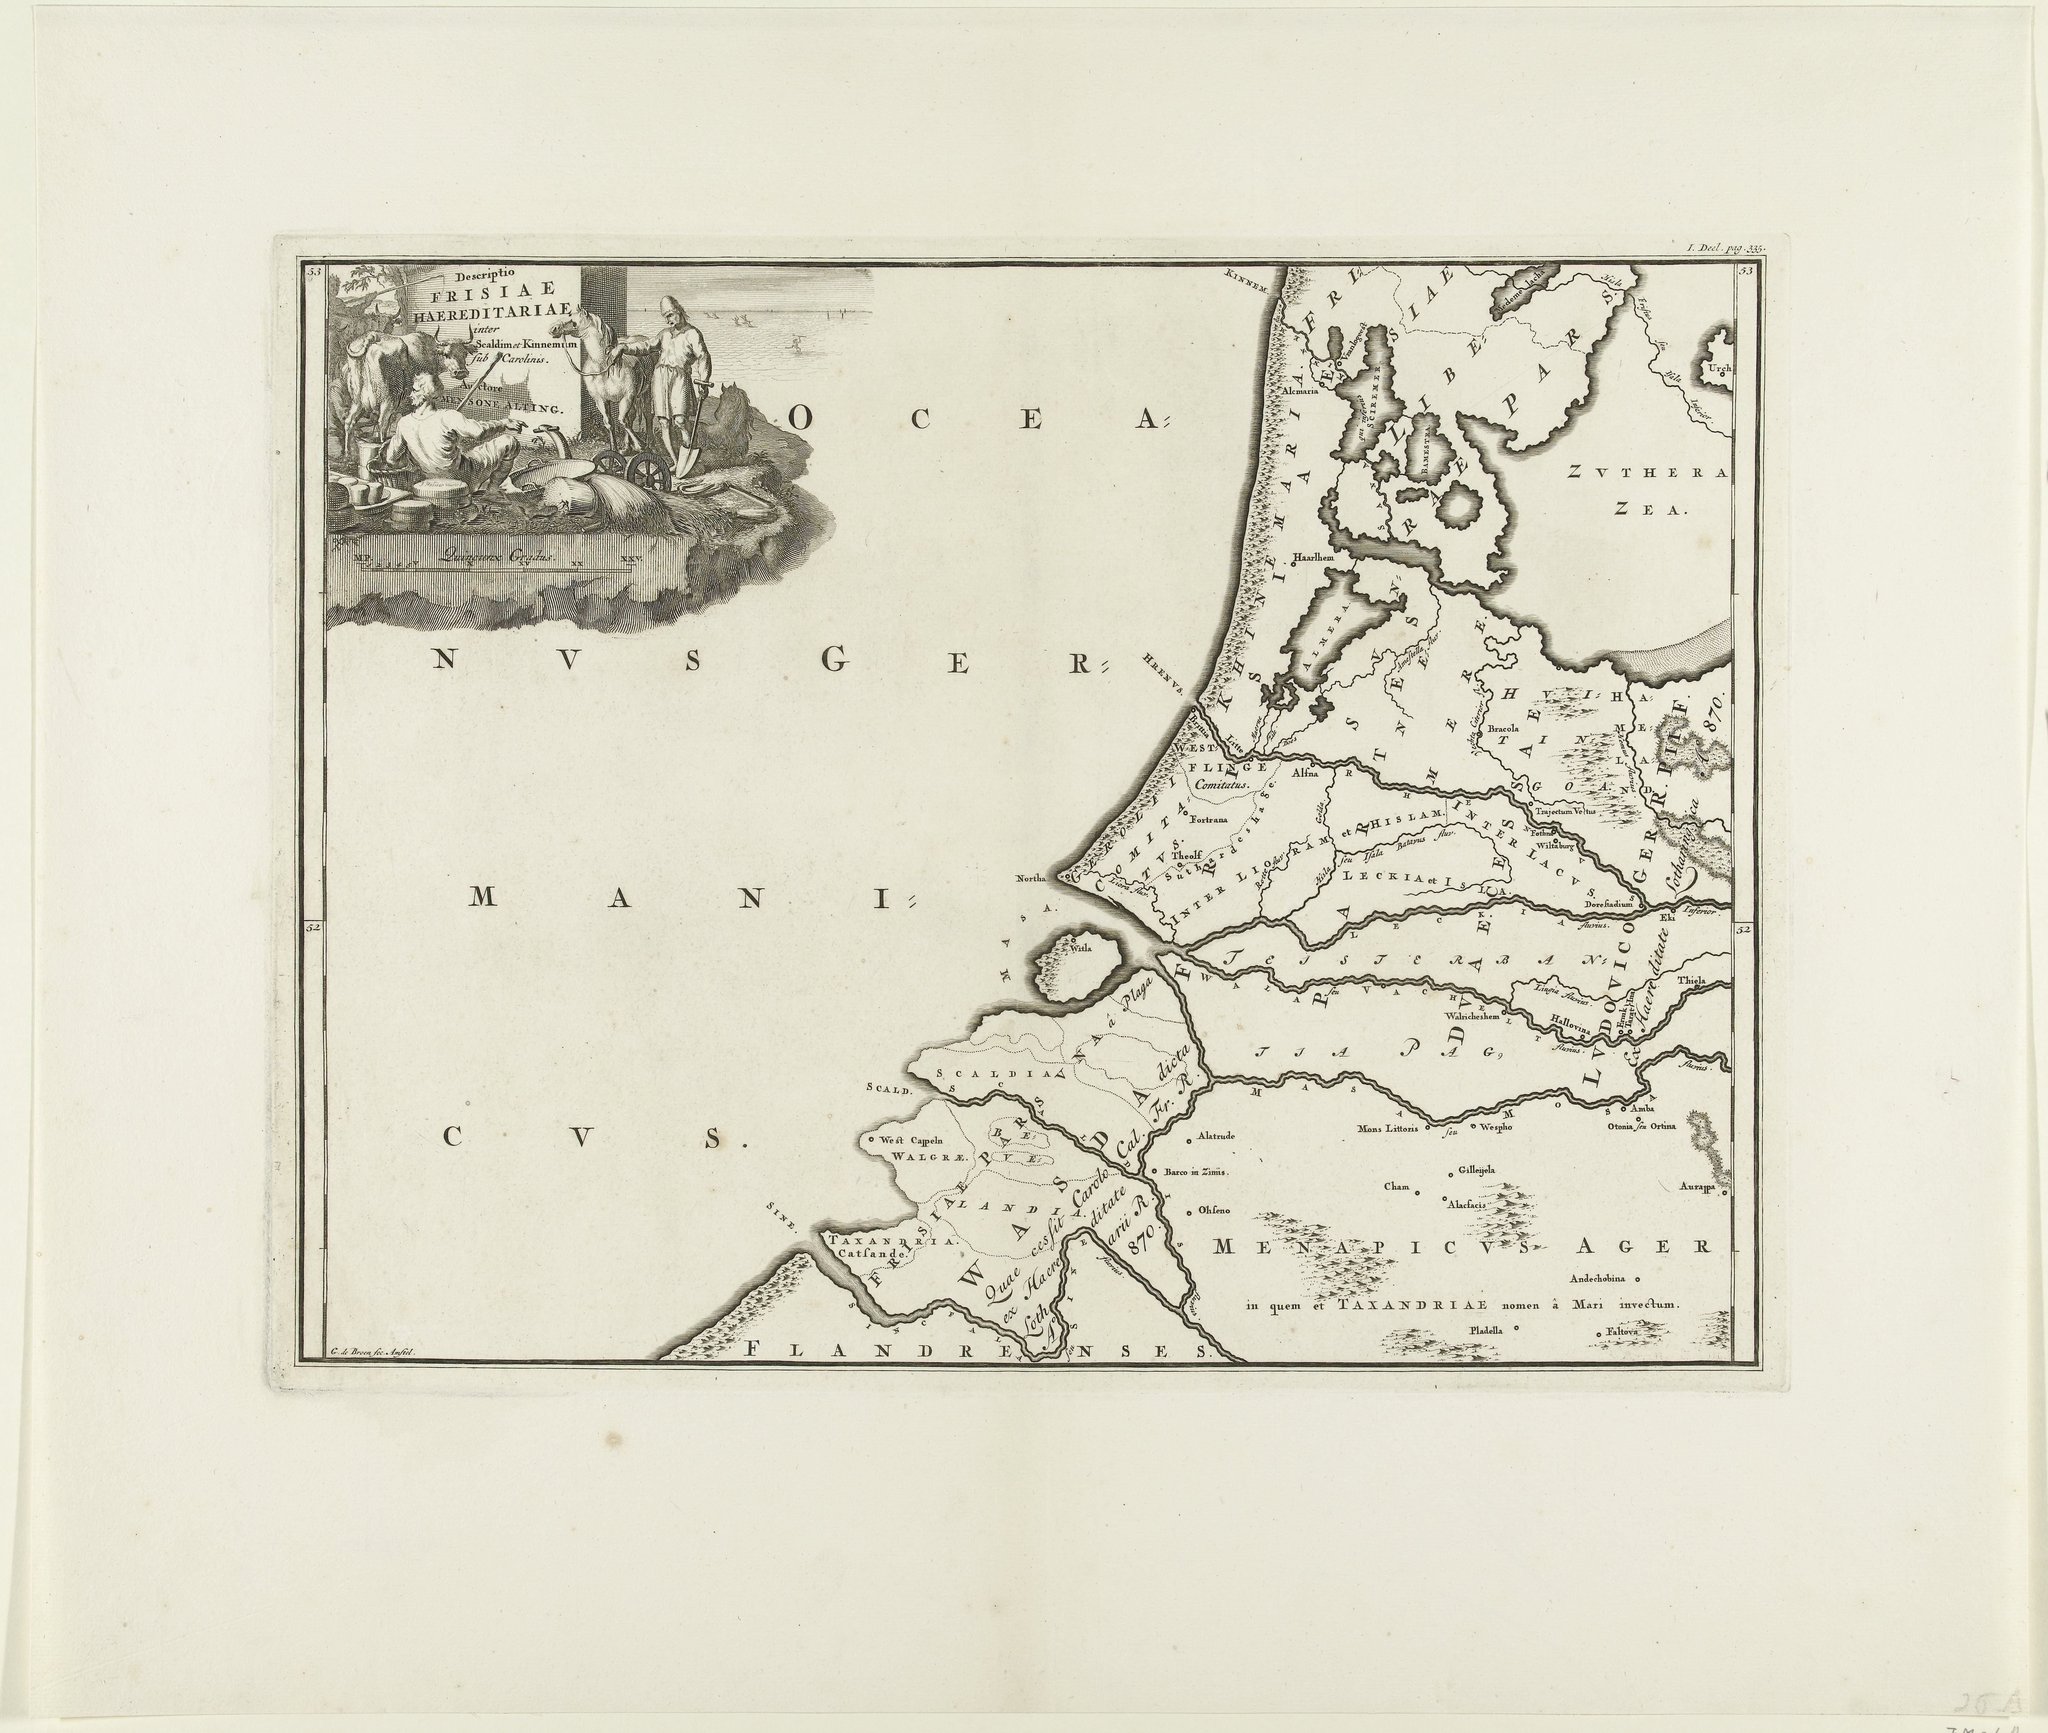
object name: history print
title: Descriptio Frisiae Haereditariae inter Scaldim et Kinnemum sub Carolinis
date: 1695-1700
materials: paper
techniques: engraving, etching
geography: amsterdam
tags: maps of separate countries or regions, netherlands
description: Kaart van de Friese gebieden in westelijk Nederland. Maakt deel uit van 16 kaarten van het land van de Bataven en de Friezen eerst vervaardigd voor en opgenomen in M. Alting, Descriptio ant. agri Batavi et Frisii, s. notitia Germ. infer., 2 delen, 1697-1700. Hergebruikt in F. Halma, Tooneel der Vereenigde Nederlanden en onderhorige landschappen, geopent in een algemeen historisch, genealogisch, geographisch en staatkundig woordenboek, 2 delen, 1725. Volgens opschrift geplaatst in: Deel I, pag. 335.